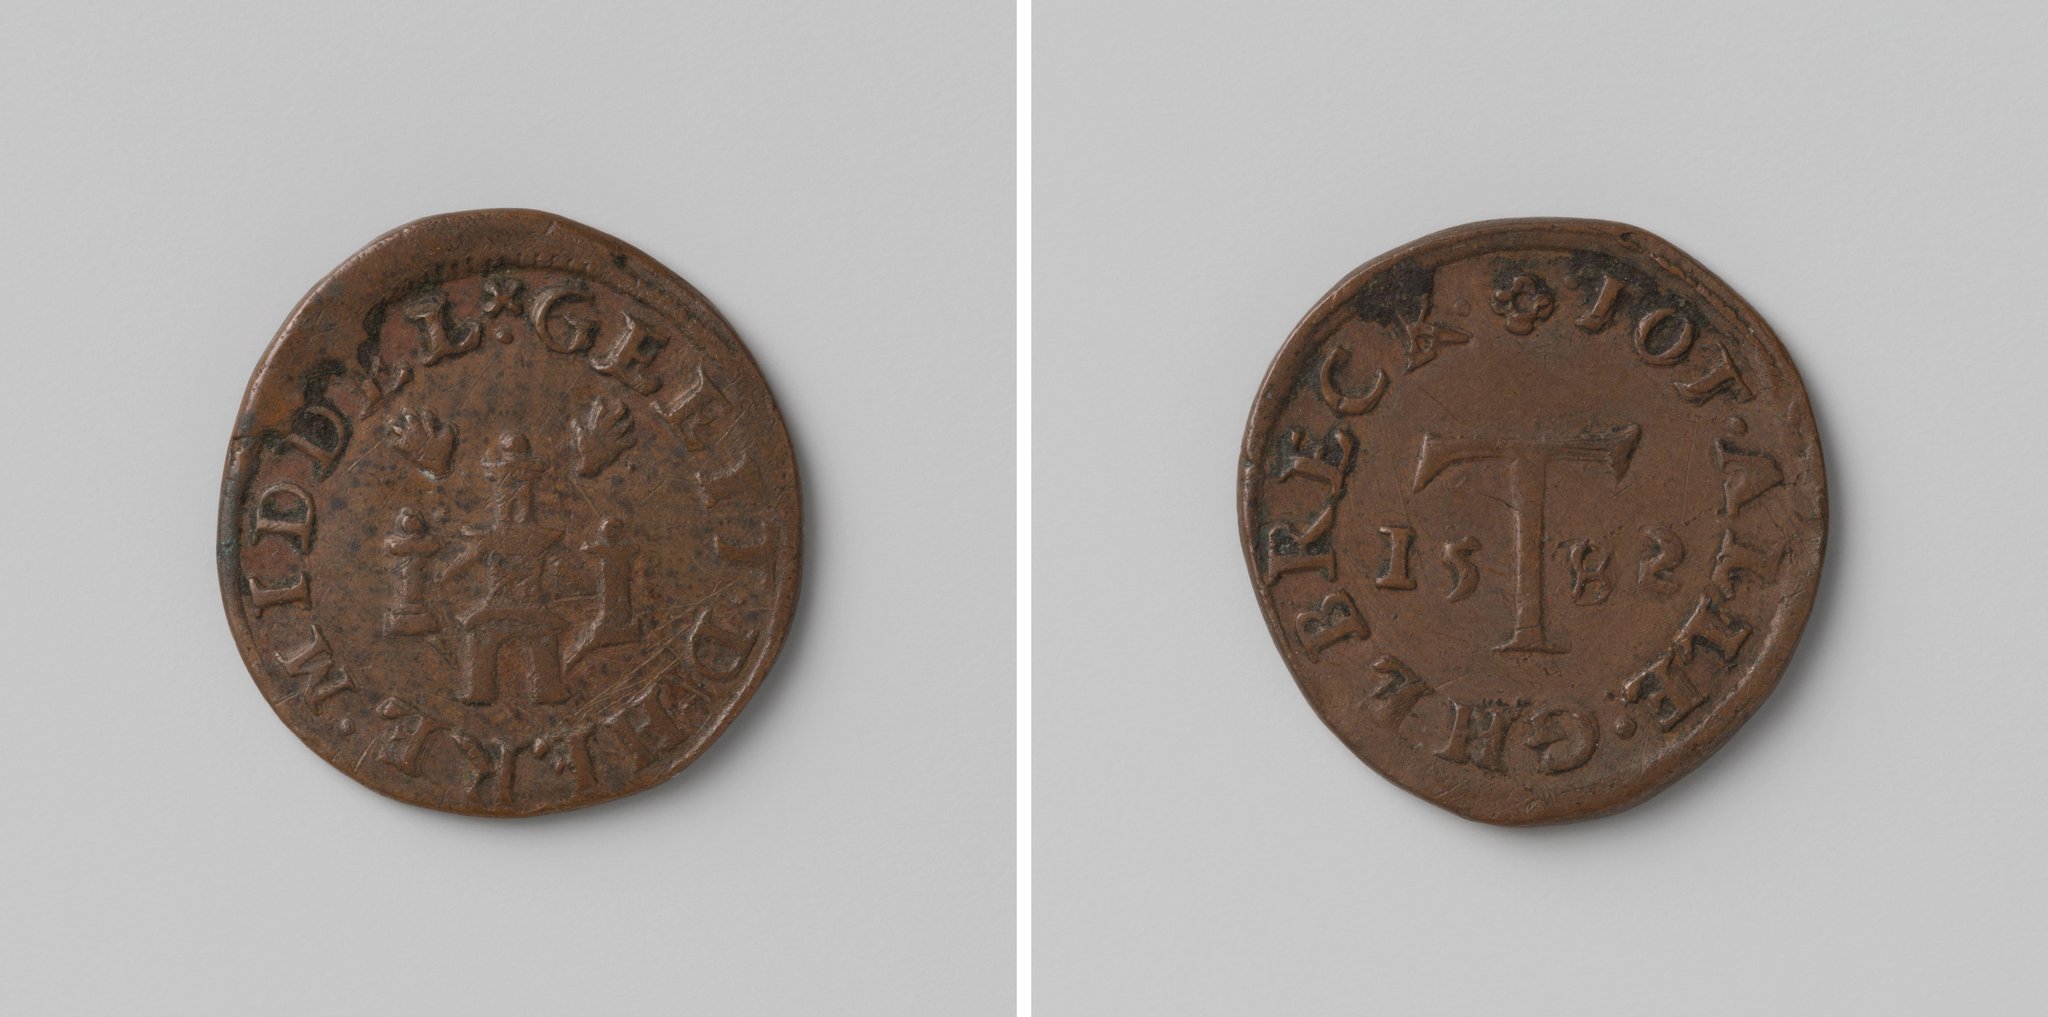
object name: turfloodje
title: Stad Antwerpen, loodje dat bij uitdeling recht gaf op turf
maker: Anonymous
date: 1583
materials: copper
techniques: striking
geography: antwerp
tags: antwerp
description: Koperen penning. Voorzijde: twee geopende handen boven burcht binnen omschrift. Keerzijde: letter T tussen jaartal binnen omschrift